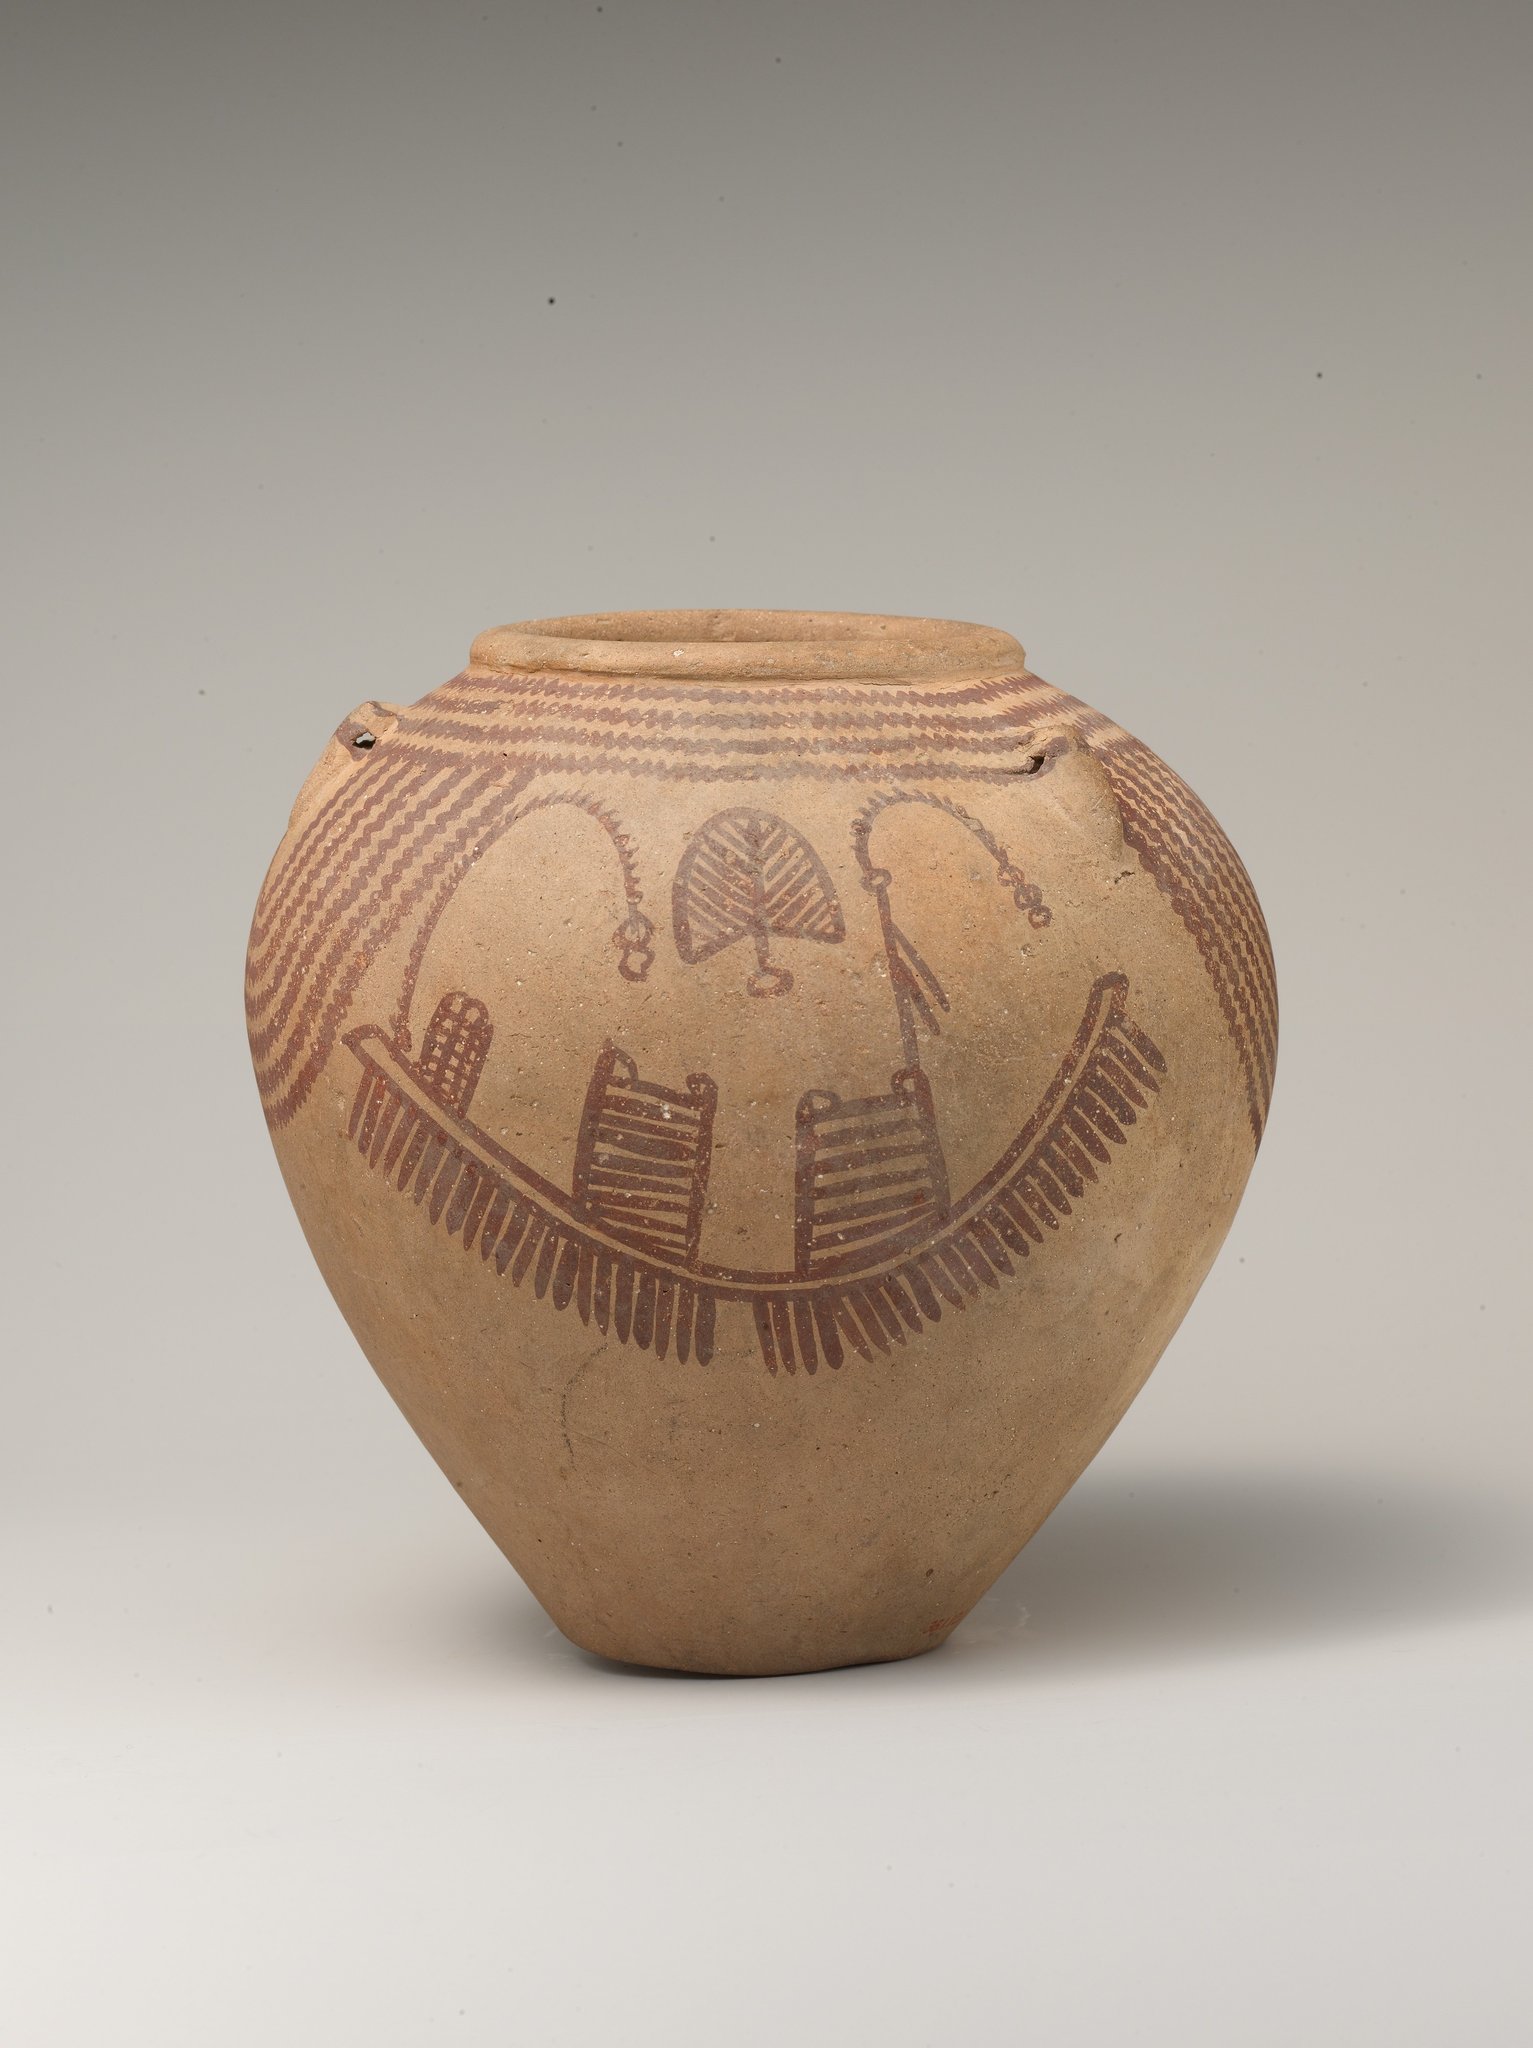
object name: jar, decorated ware, boat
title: Decorated ware jar depicting boats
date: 3500-3300 BCE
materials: paint, pottery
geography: egypt